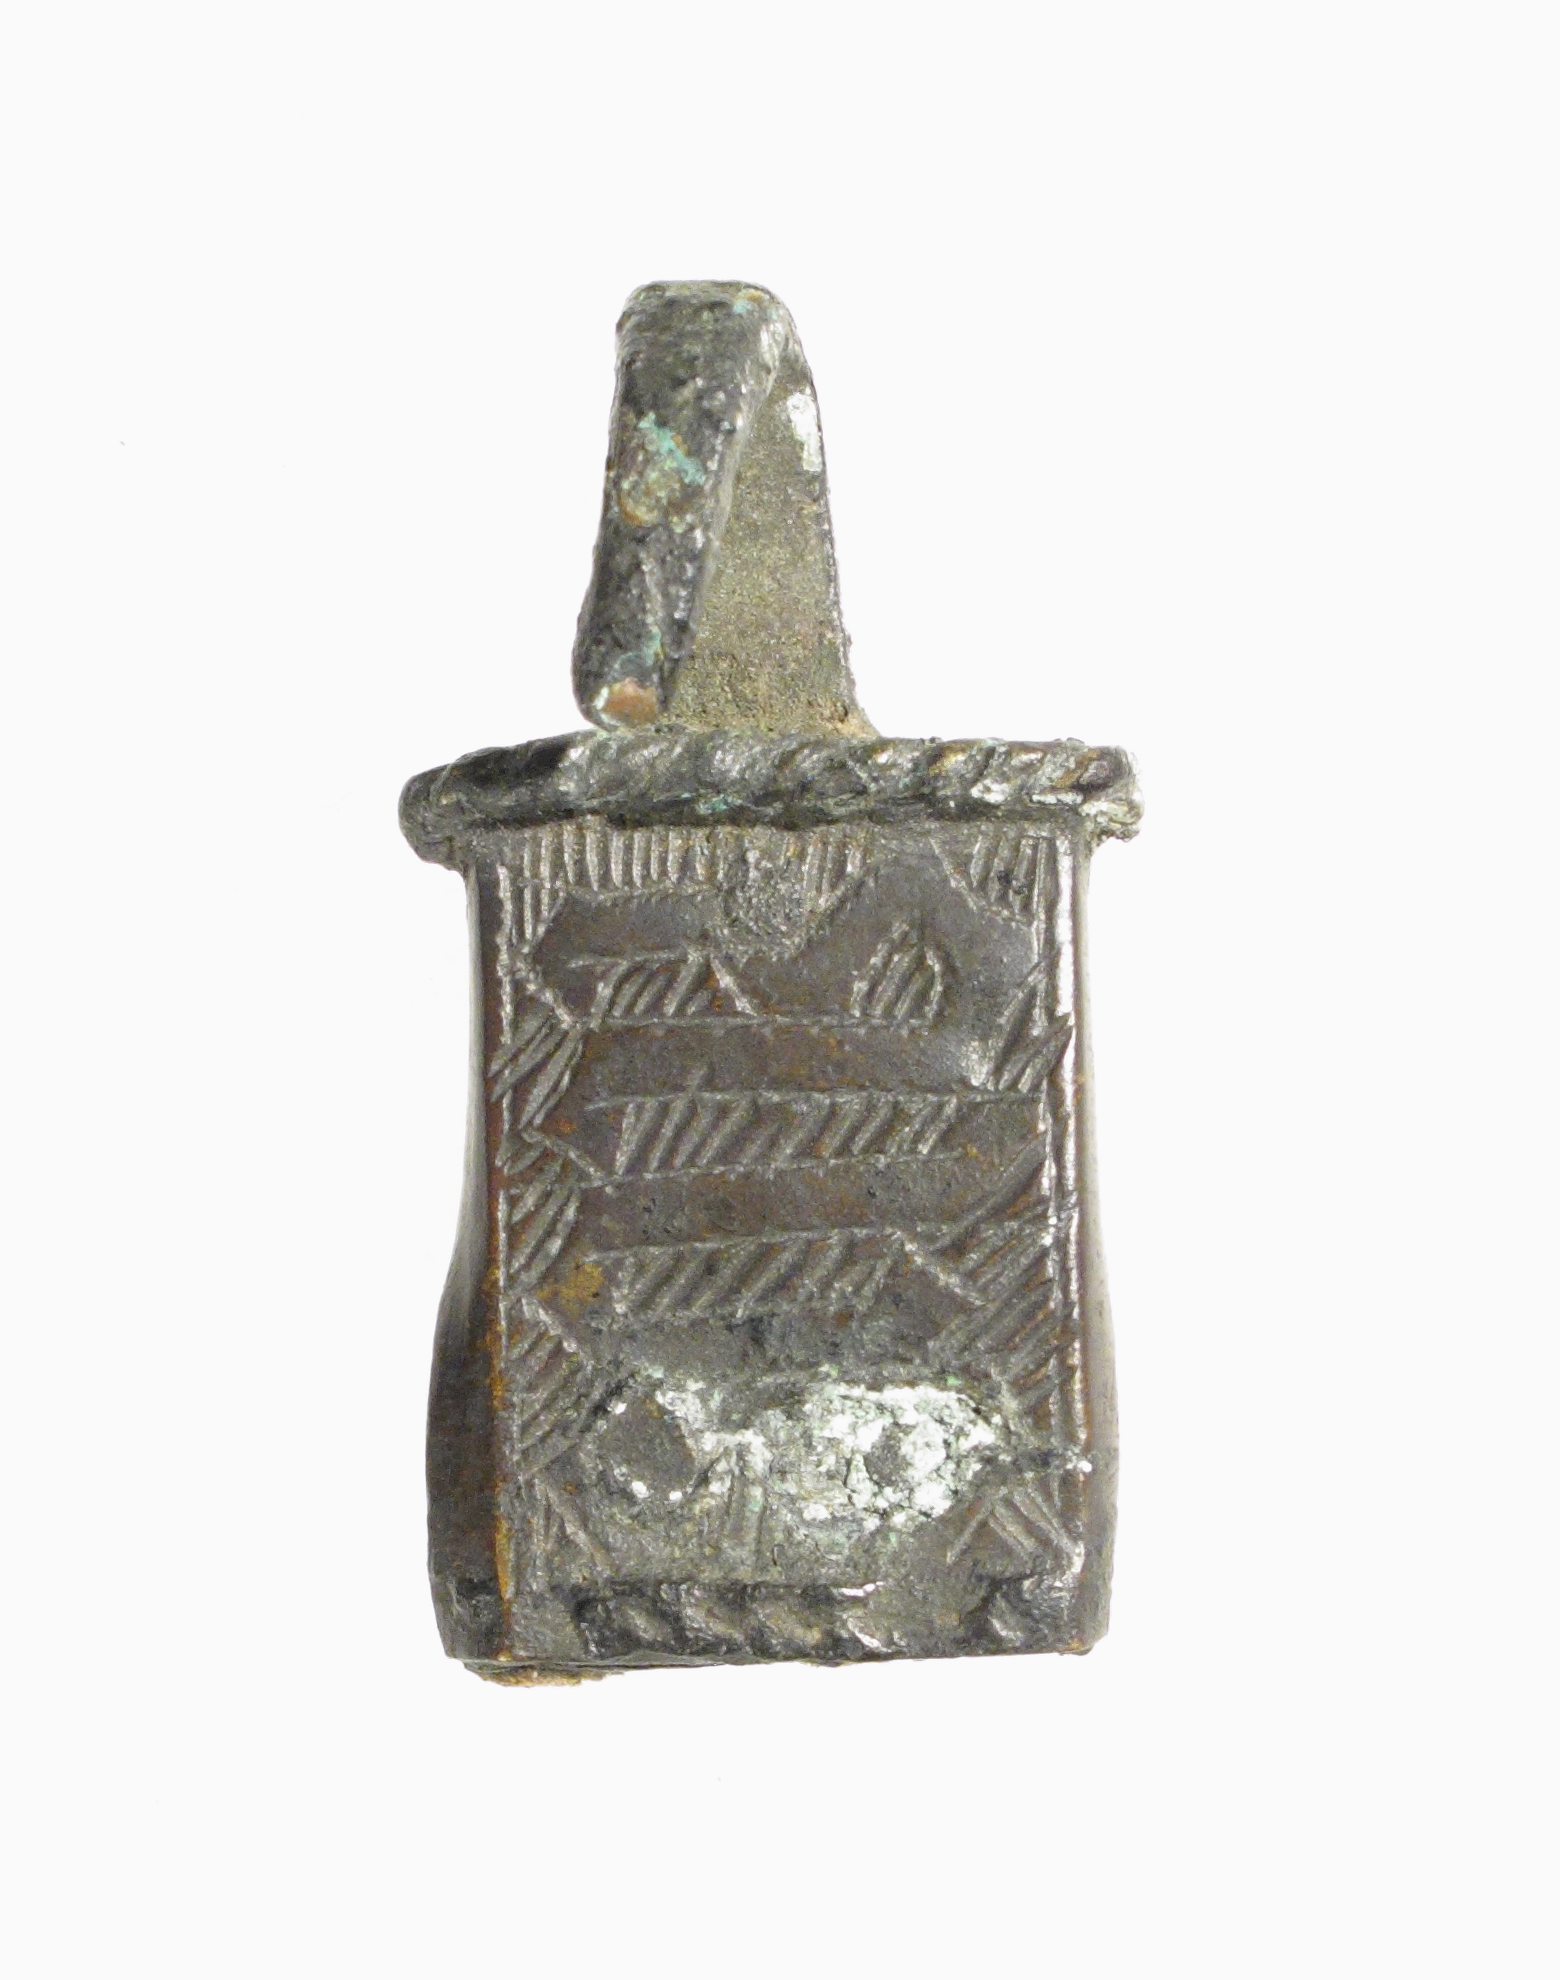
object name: pilgrim's badge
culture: french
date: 1301-1600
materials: lead